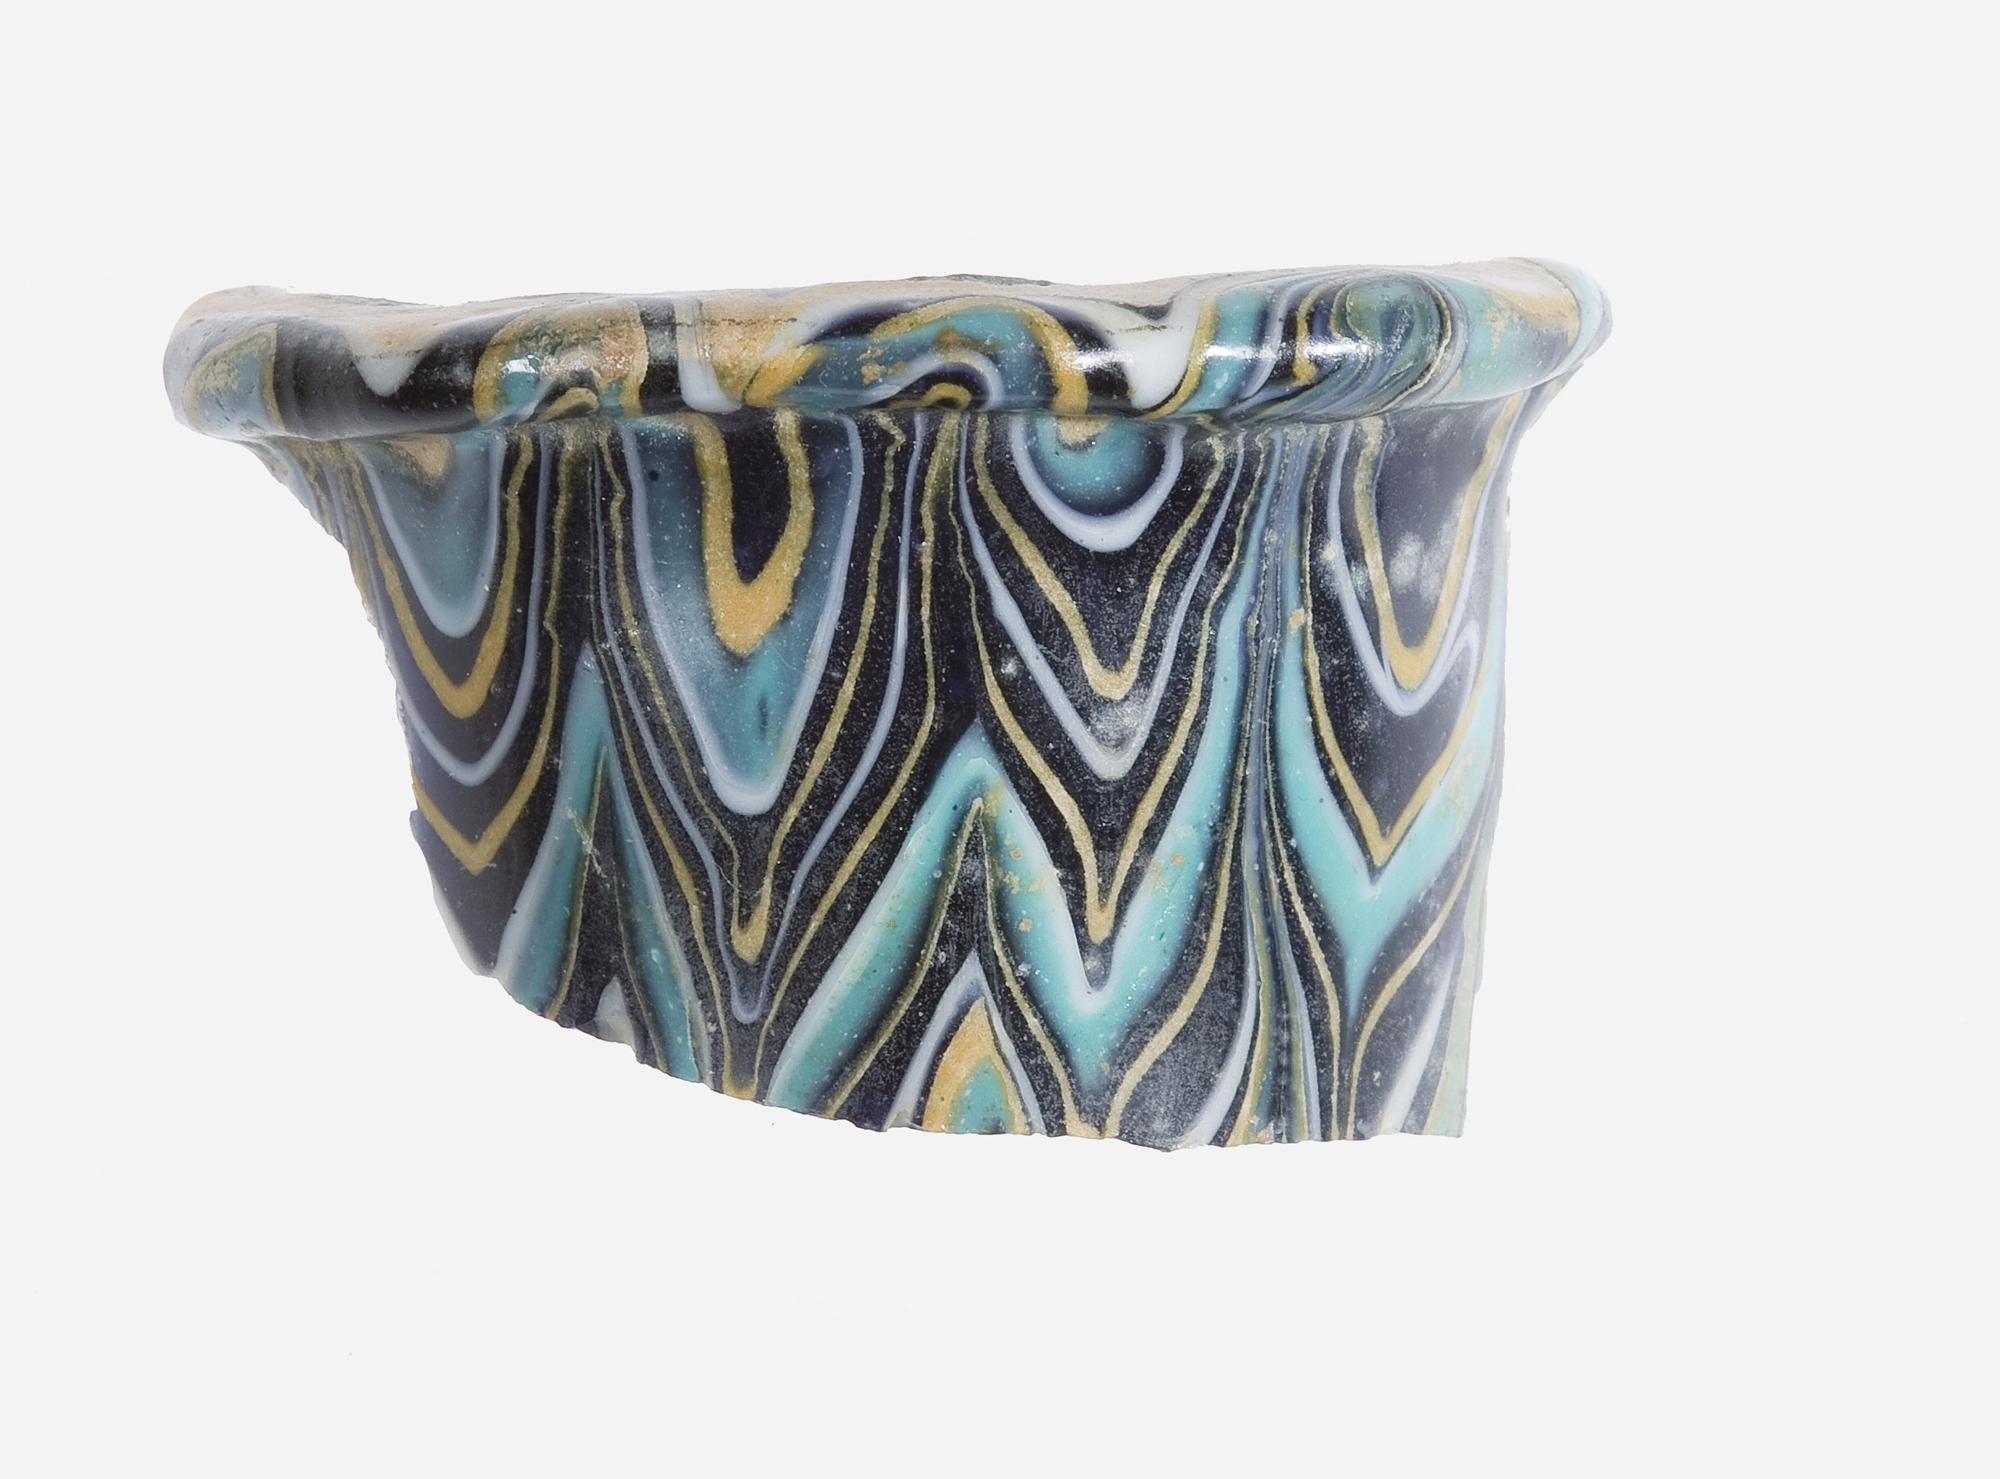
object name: neck fragment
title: Neck Fragment of a Glass Vase with Dragged Decoration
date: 1390-1352 BCE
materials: glass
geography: egypt